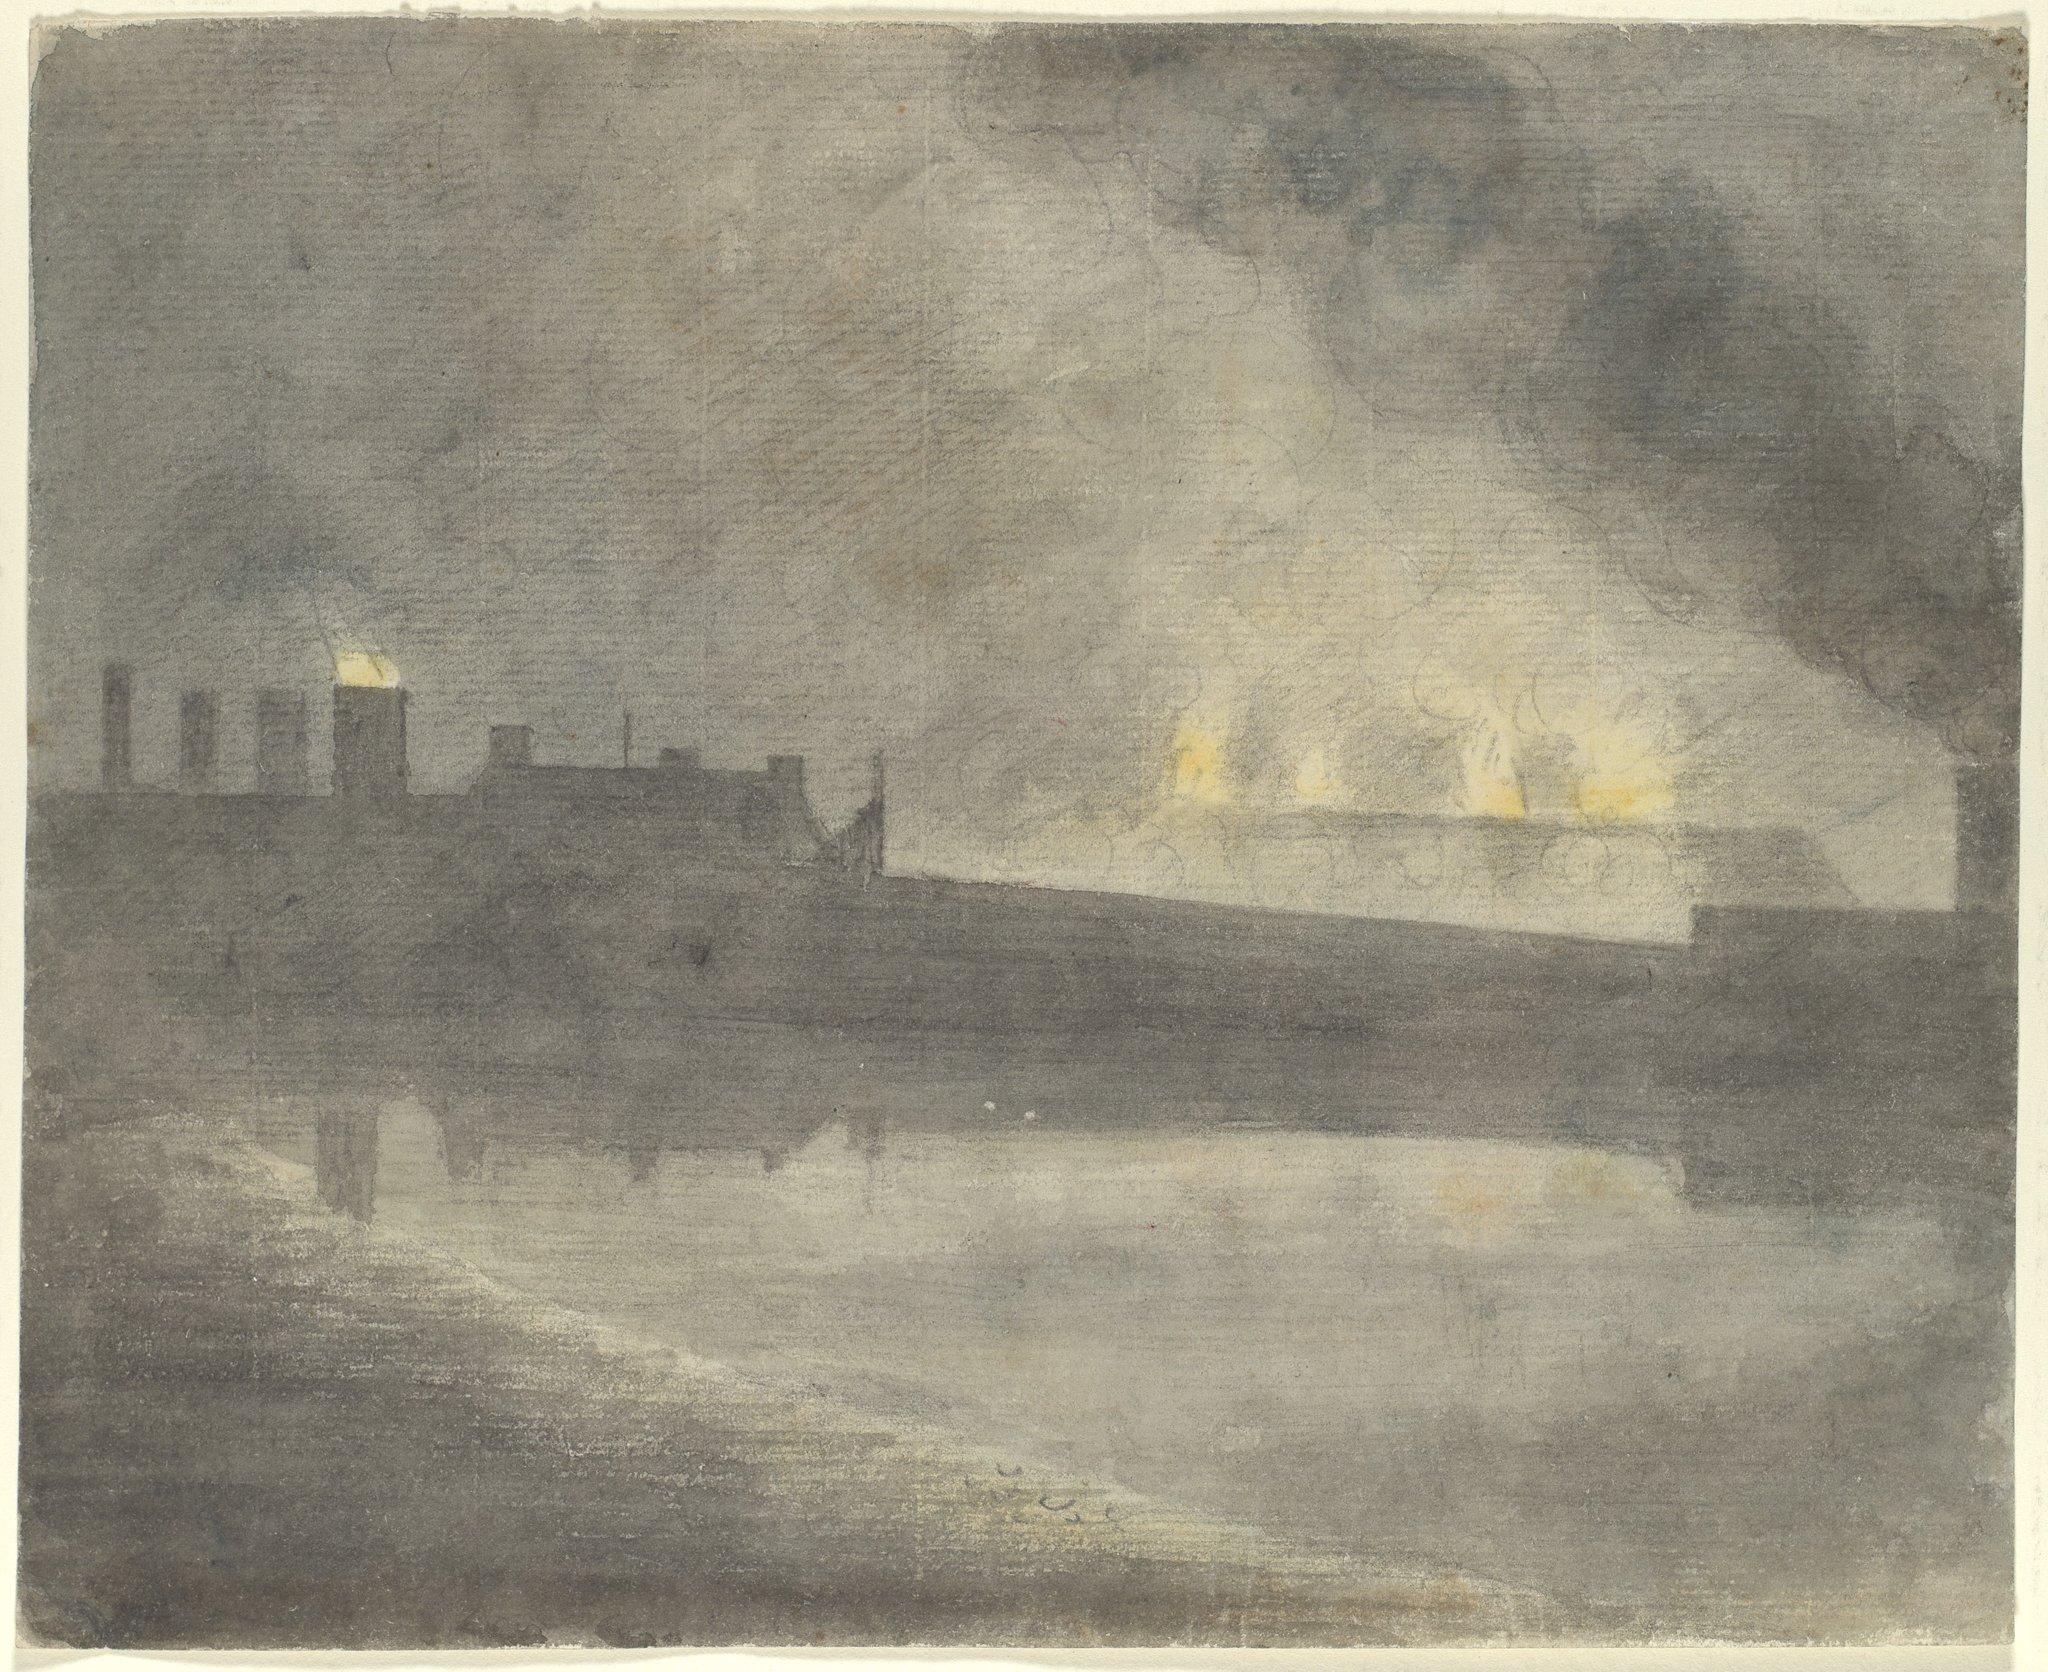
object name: drawing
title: Foundry at Canon, Herefordshire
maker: john baptist malchair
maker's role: artist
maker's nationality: british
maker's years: 1731-1812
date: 1792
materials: graphite, watercolor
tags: buildings,factories,rivers